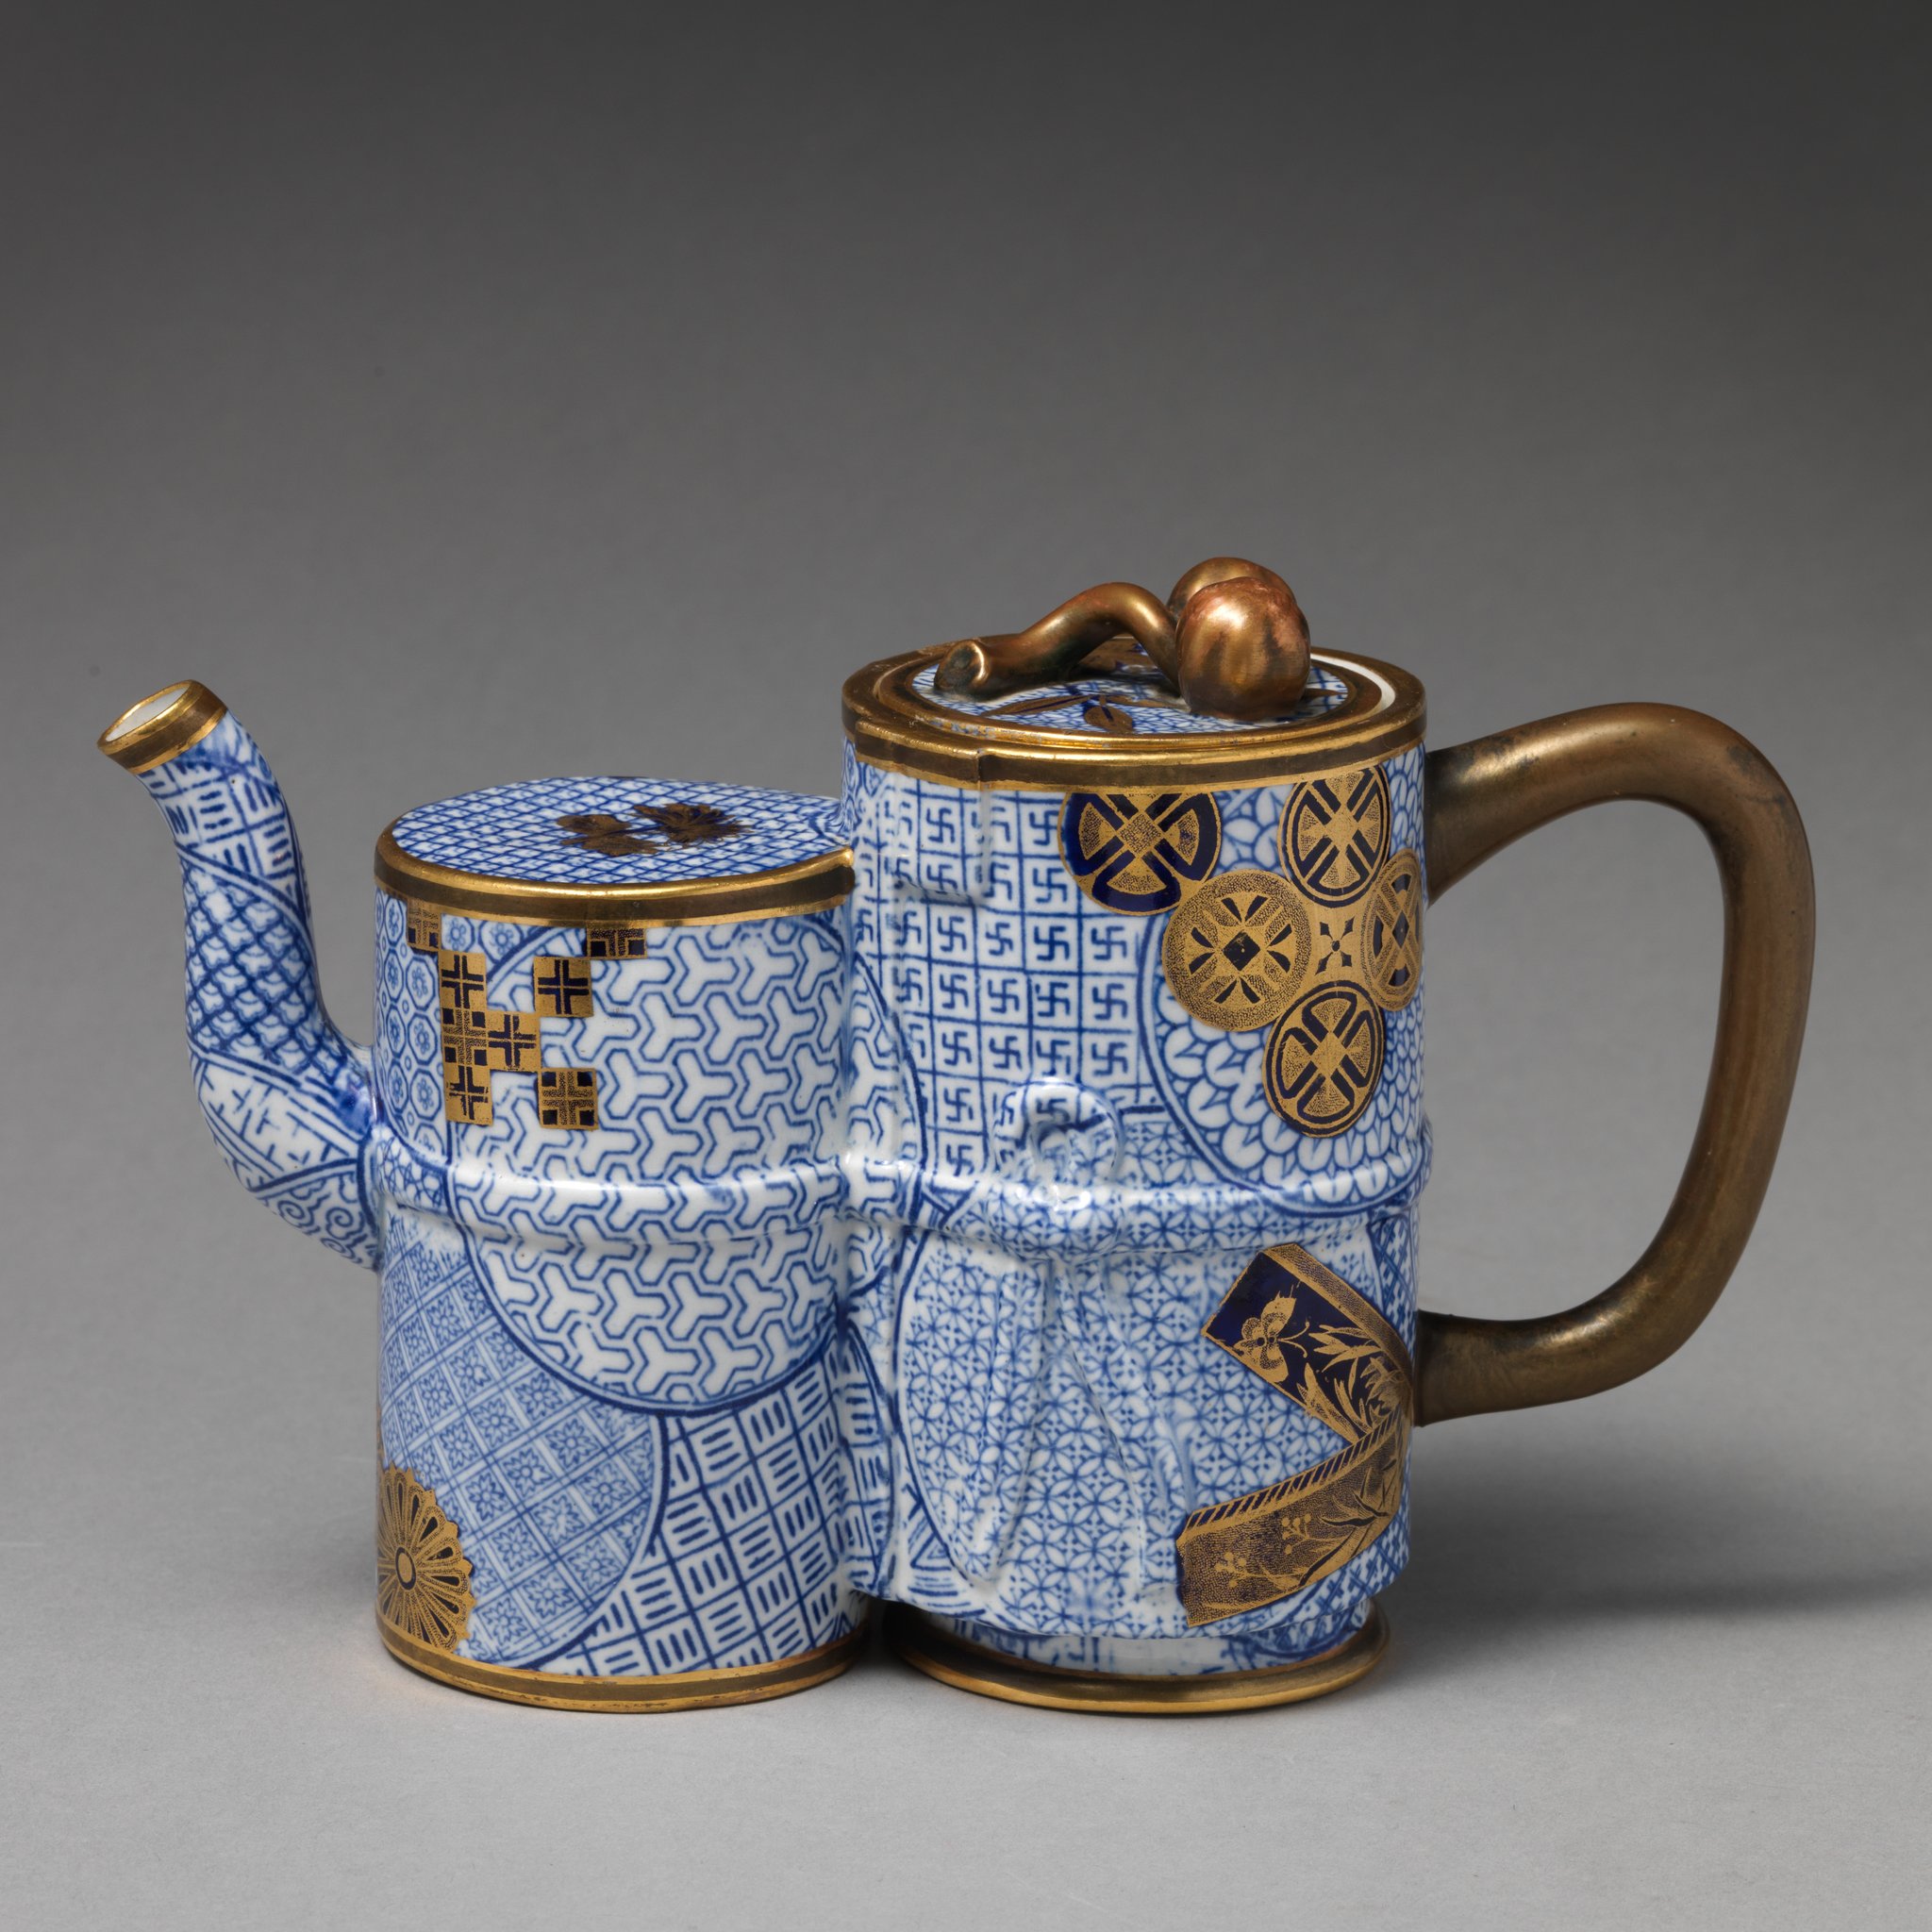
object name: teapot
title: Teapot with double bamboo body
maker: worcester factory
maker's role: maker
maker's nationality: british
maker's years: 1751-2008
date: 1878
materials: bone china